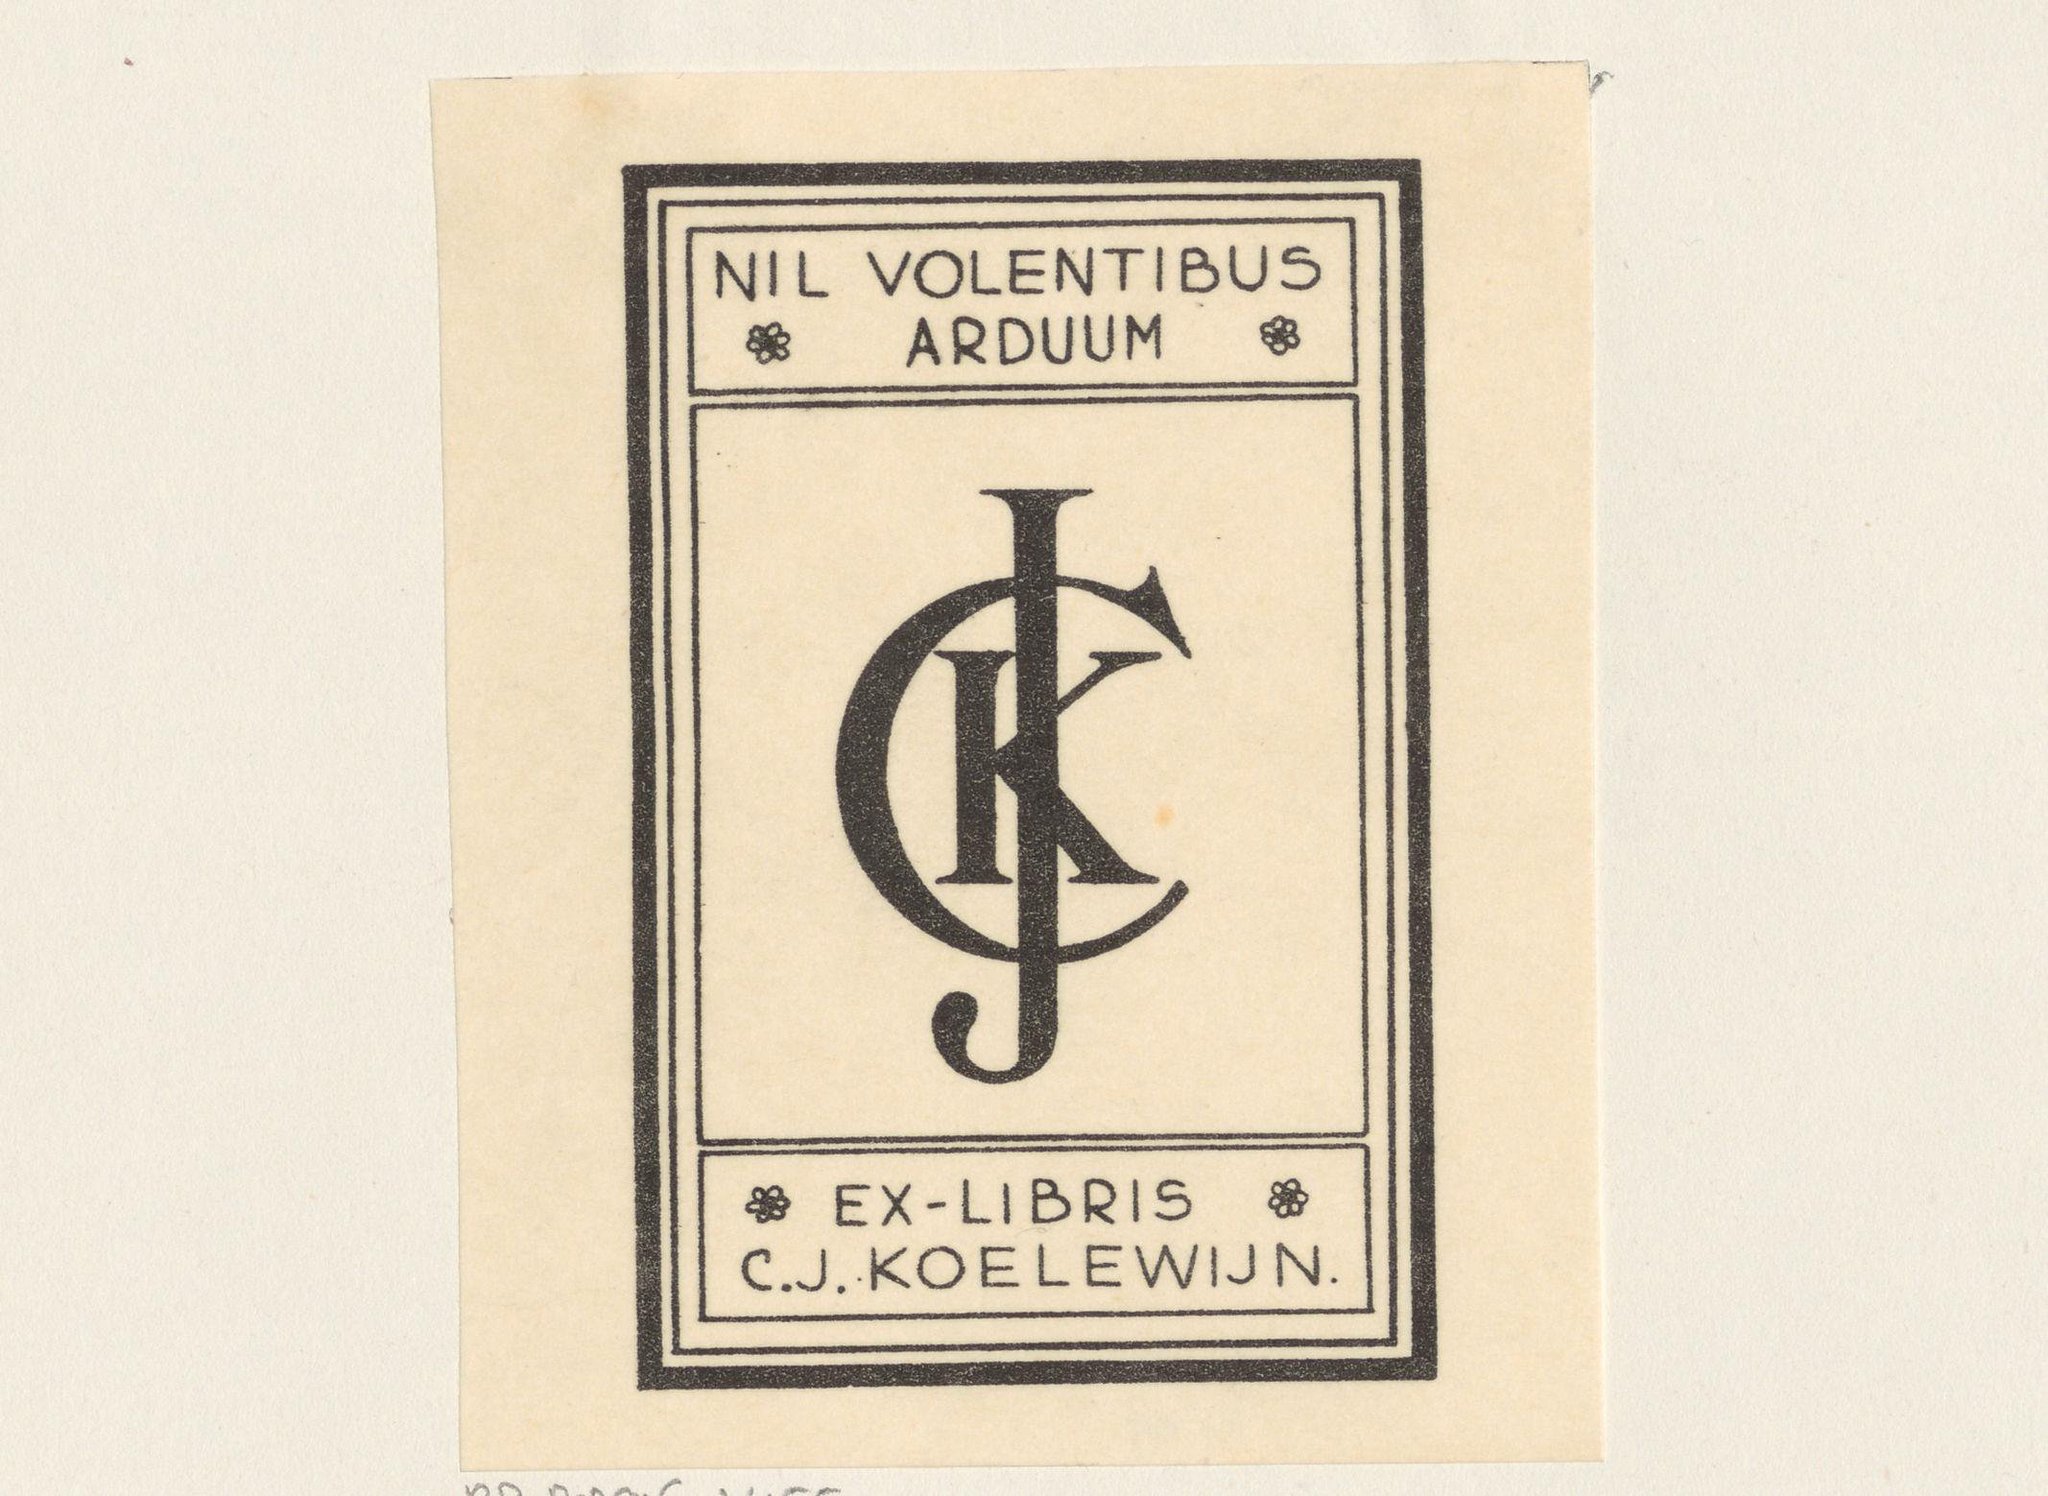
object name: bookplate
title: Ex libris van C.J. Koelewijn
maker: Anonymous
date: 1900-1999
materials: paper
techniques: printing block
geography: netherlands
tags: c.j. koelewijn